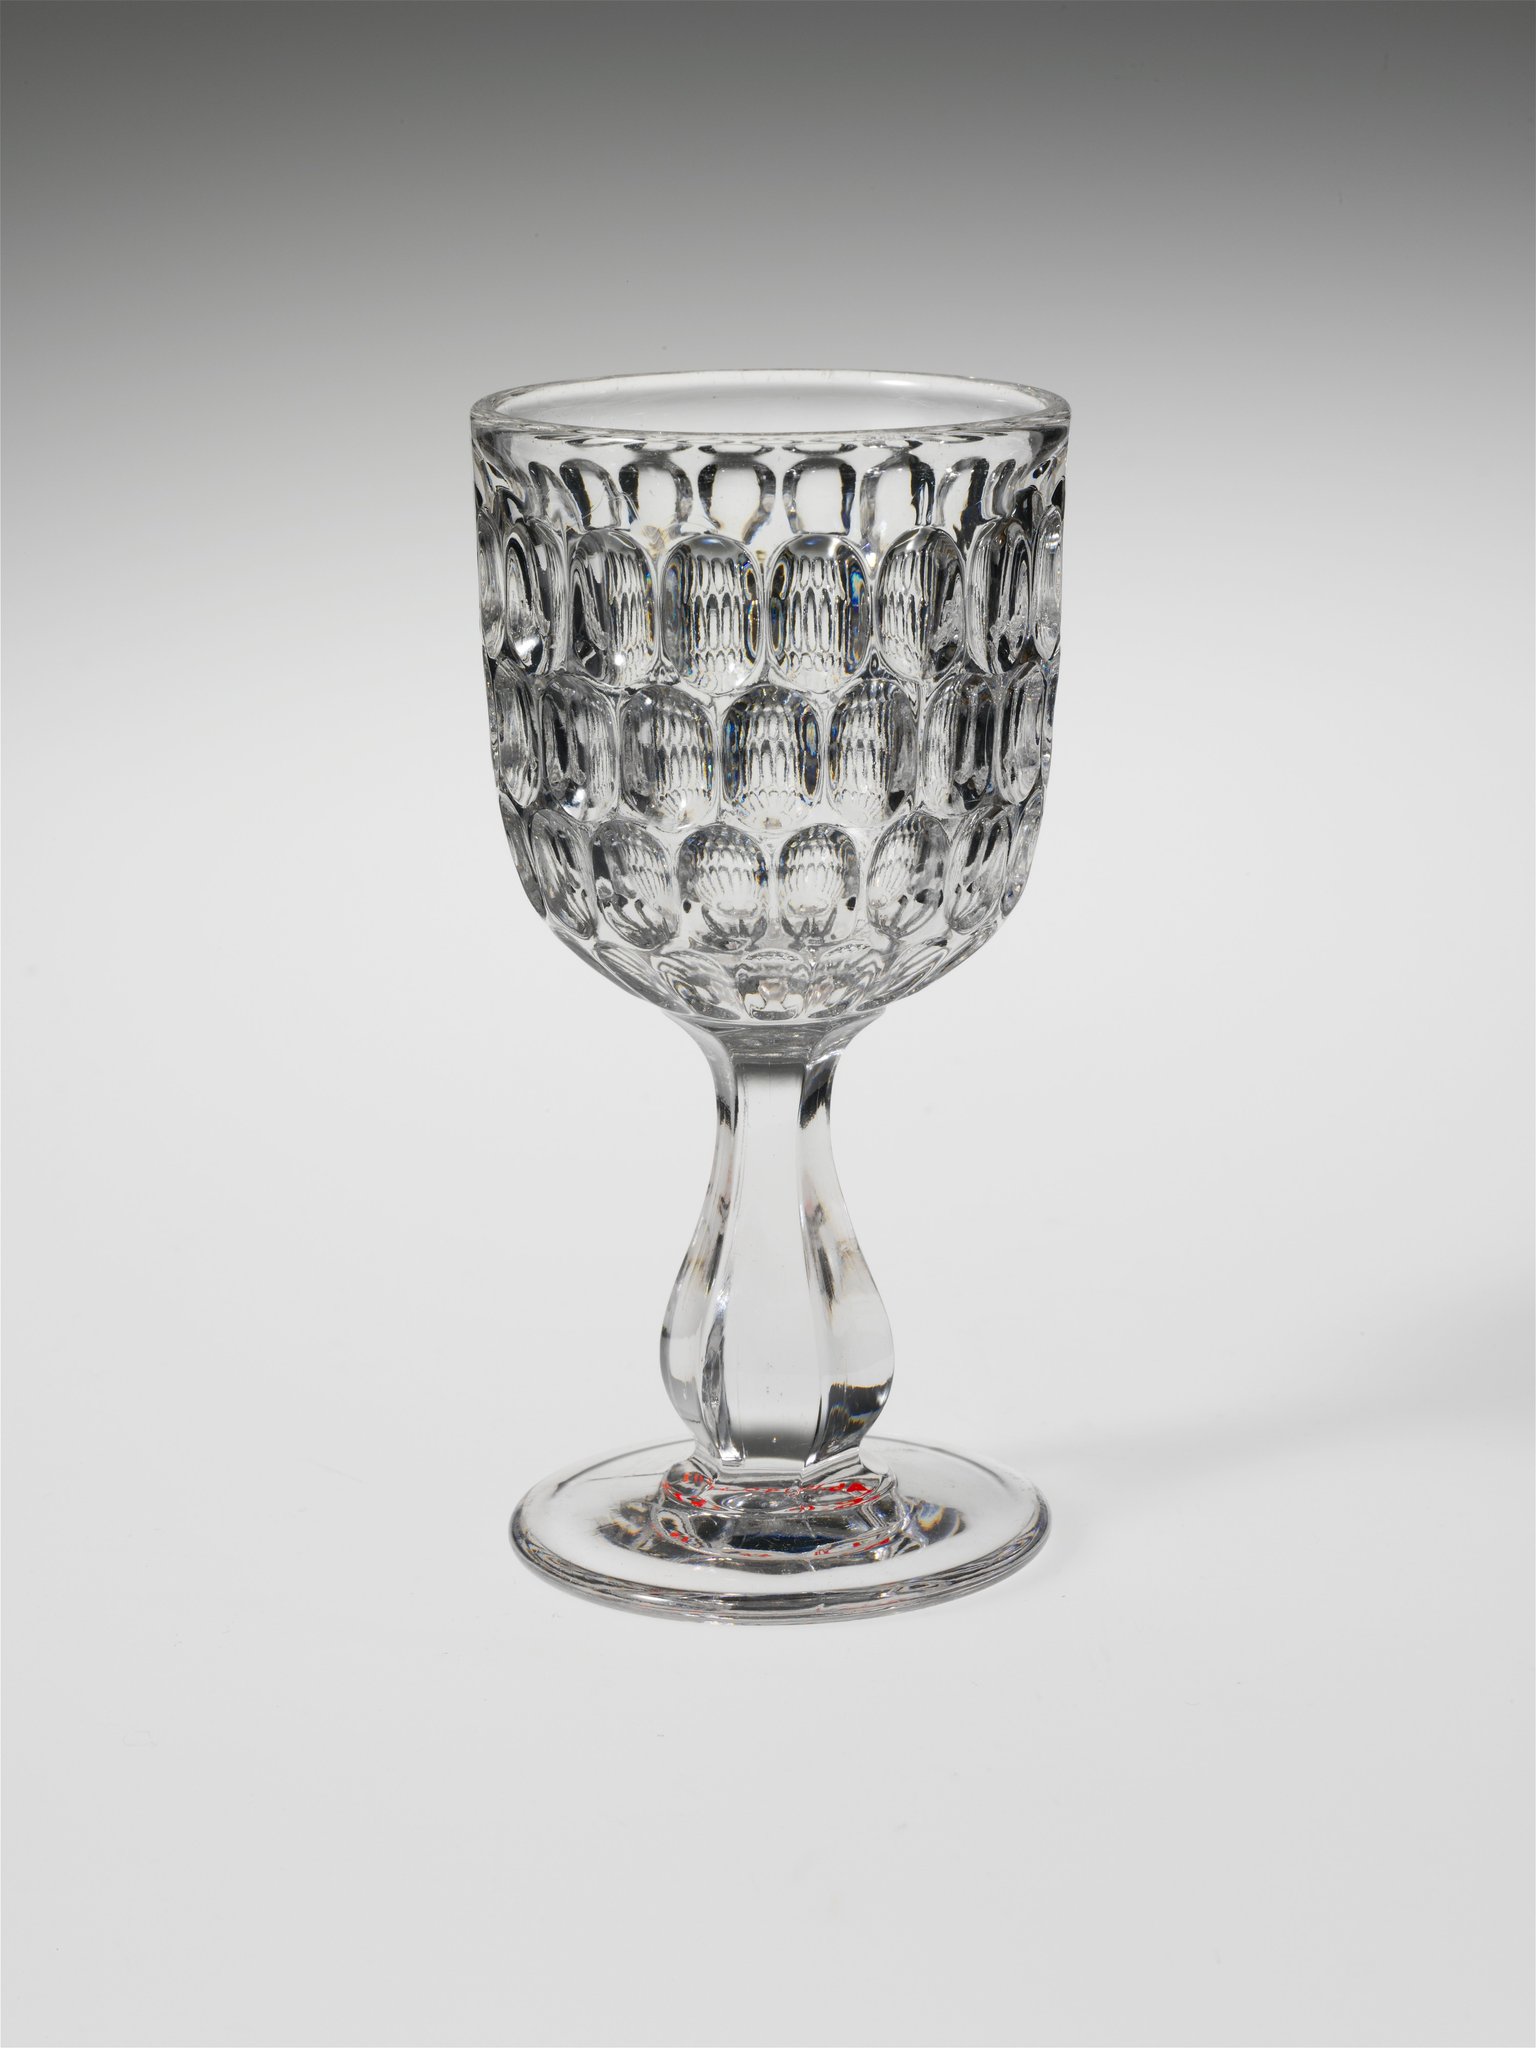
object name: champagne glass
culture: american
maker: bakewell, pears and company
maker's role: maker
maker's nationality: american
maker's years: 1836-1882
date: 1850-1870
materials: glass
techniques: pressed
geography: united states